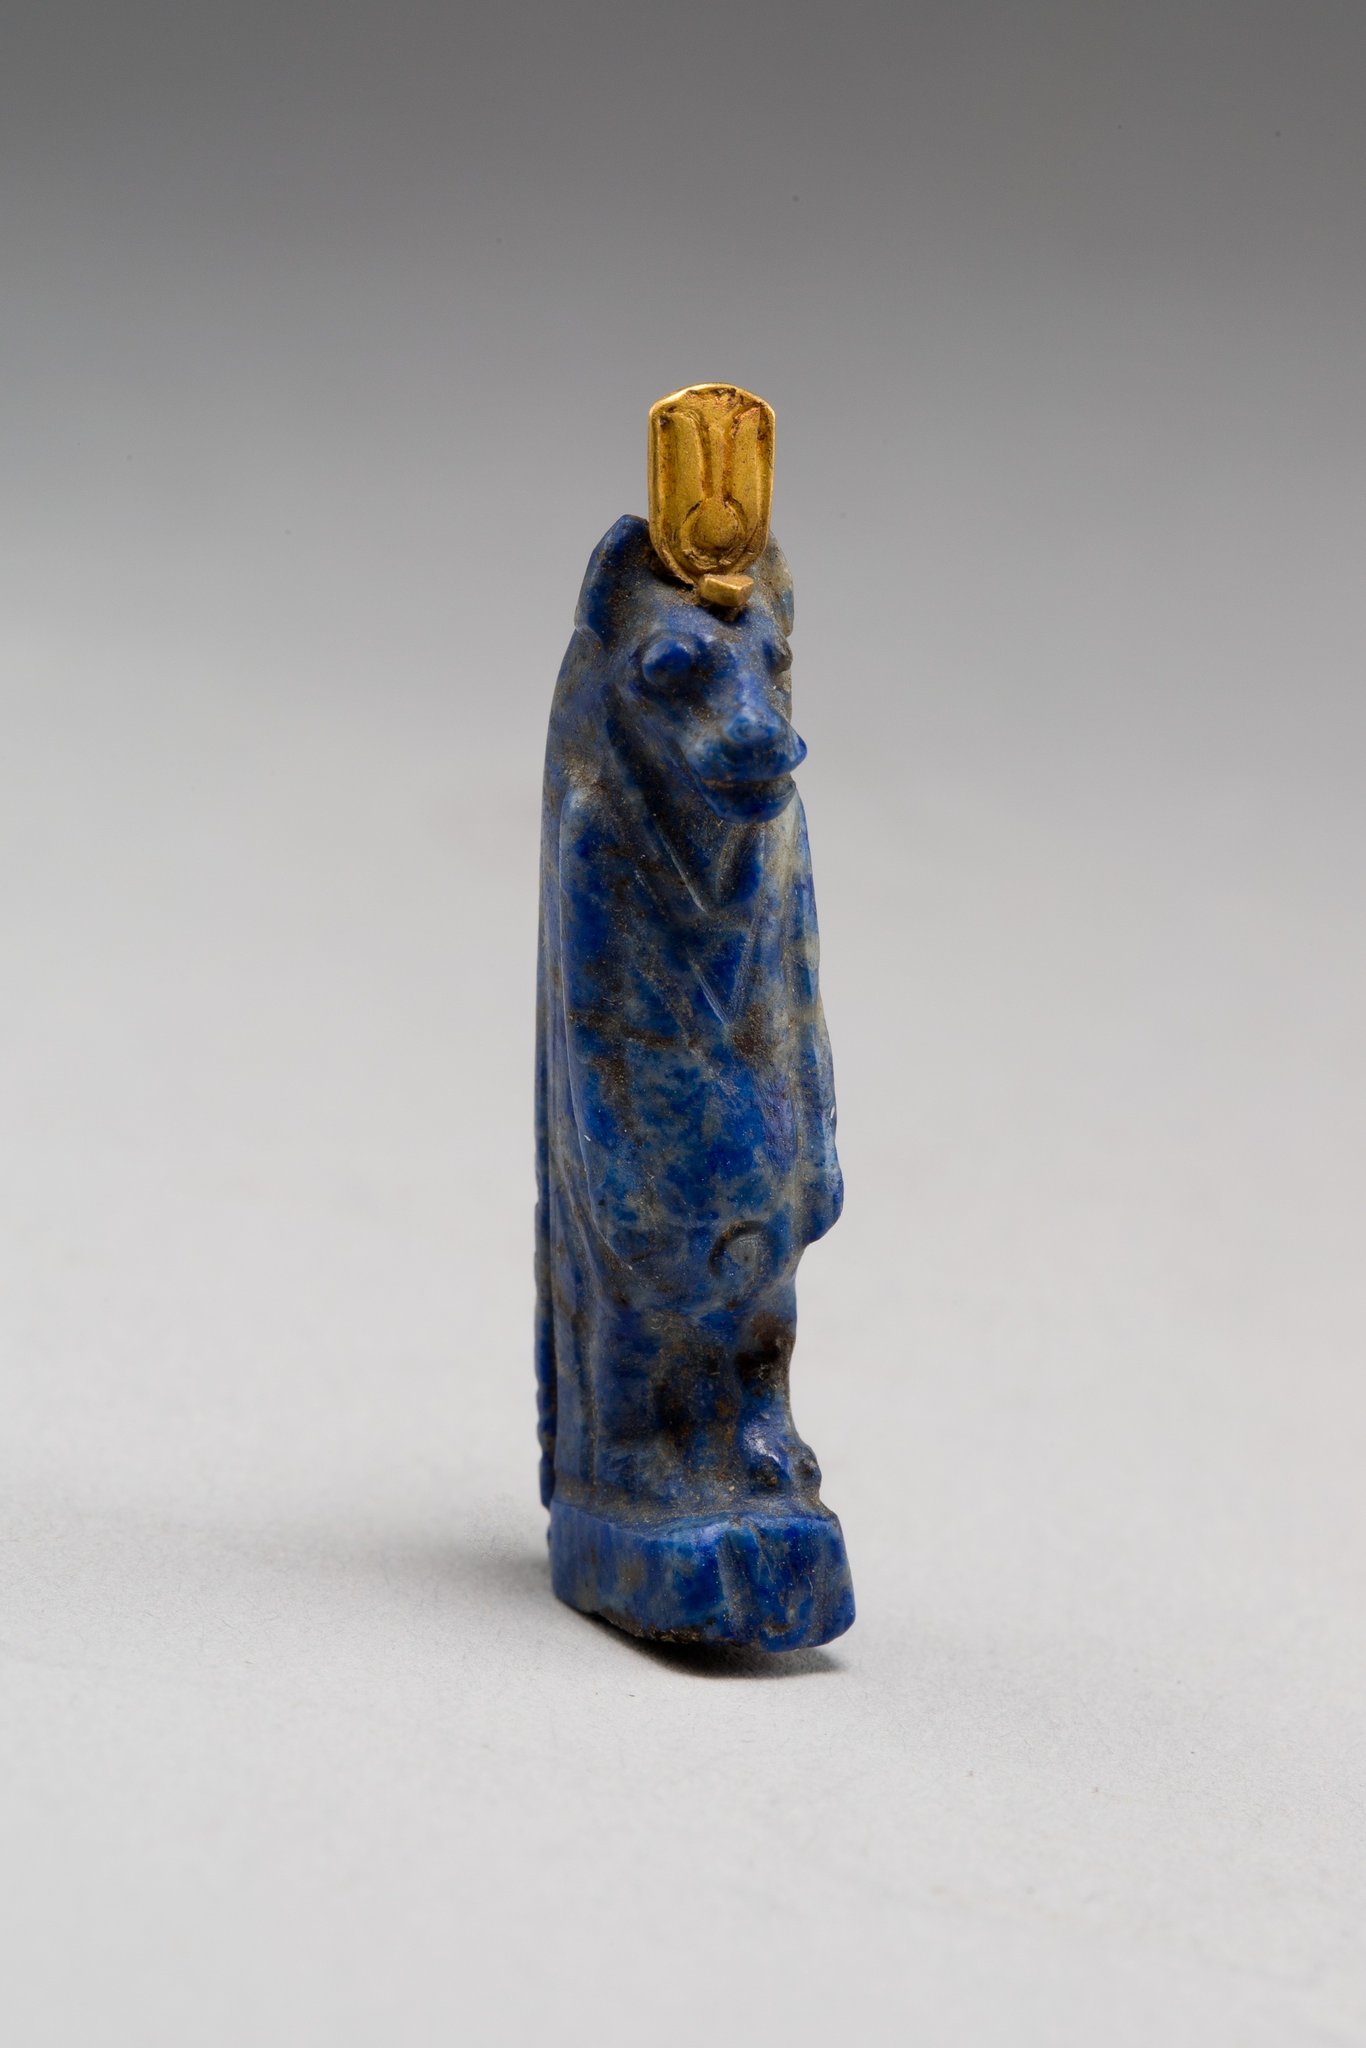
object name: amulet, taweret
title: Taweret amulet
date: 664-630 BCE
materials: gold, lapis lazuli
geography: egypt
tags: taweret